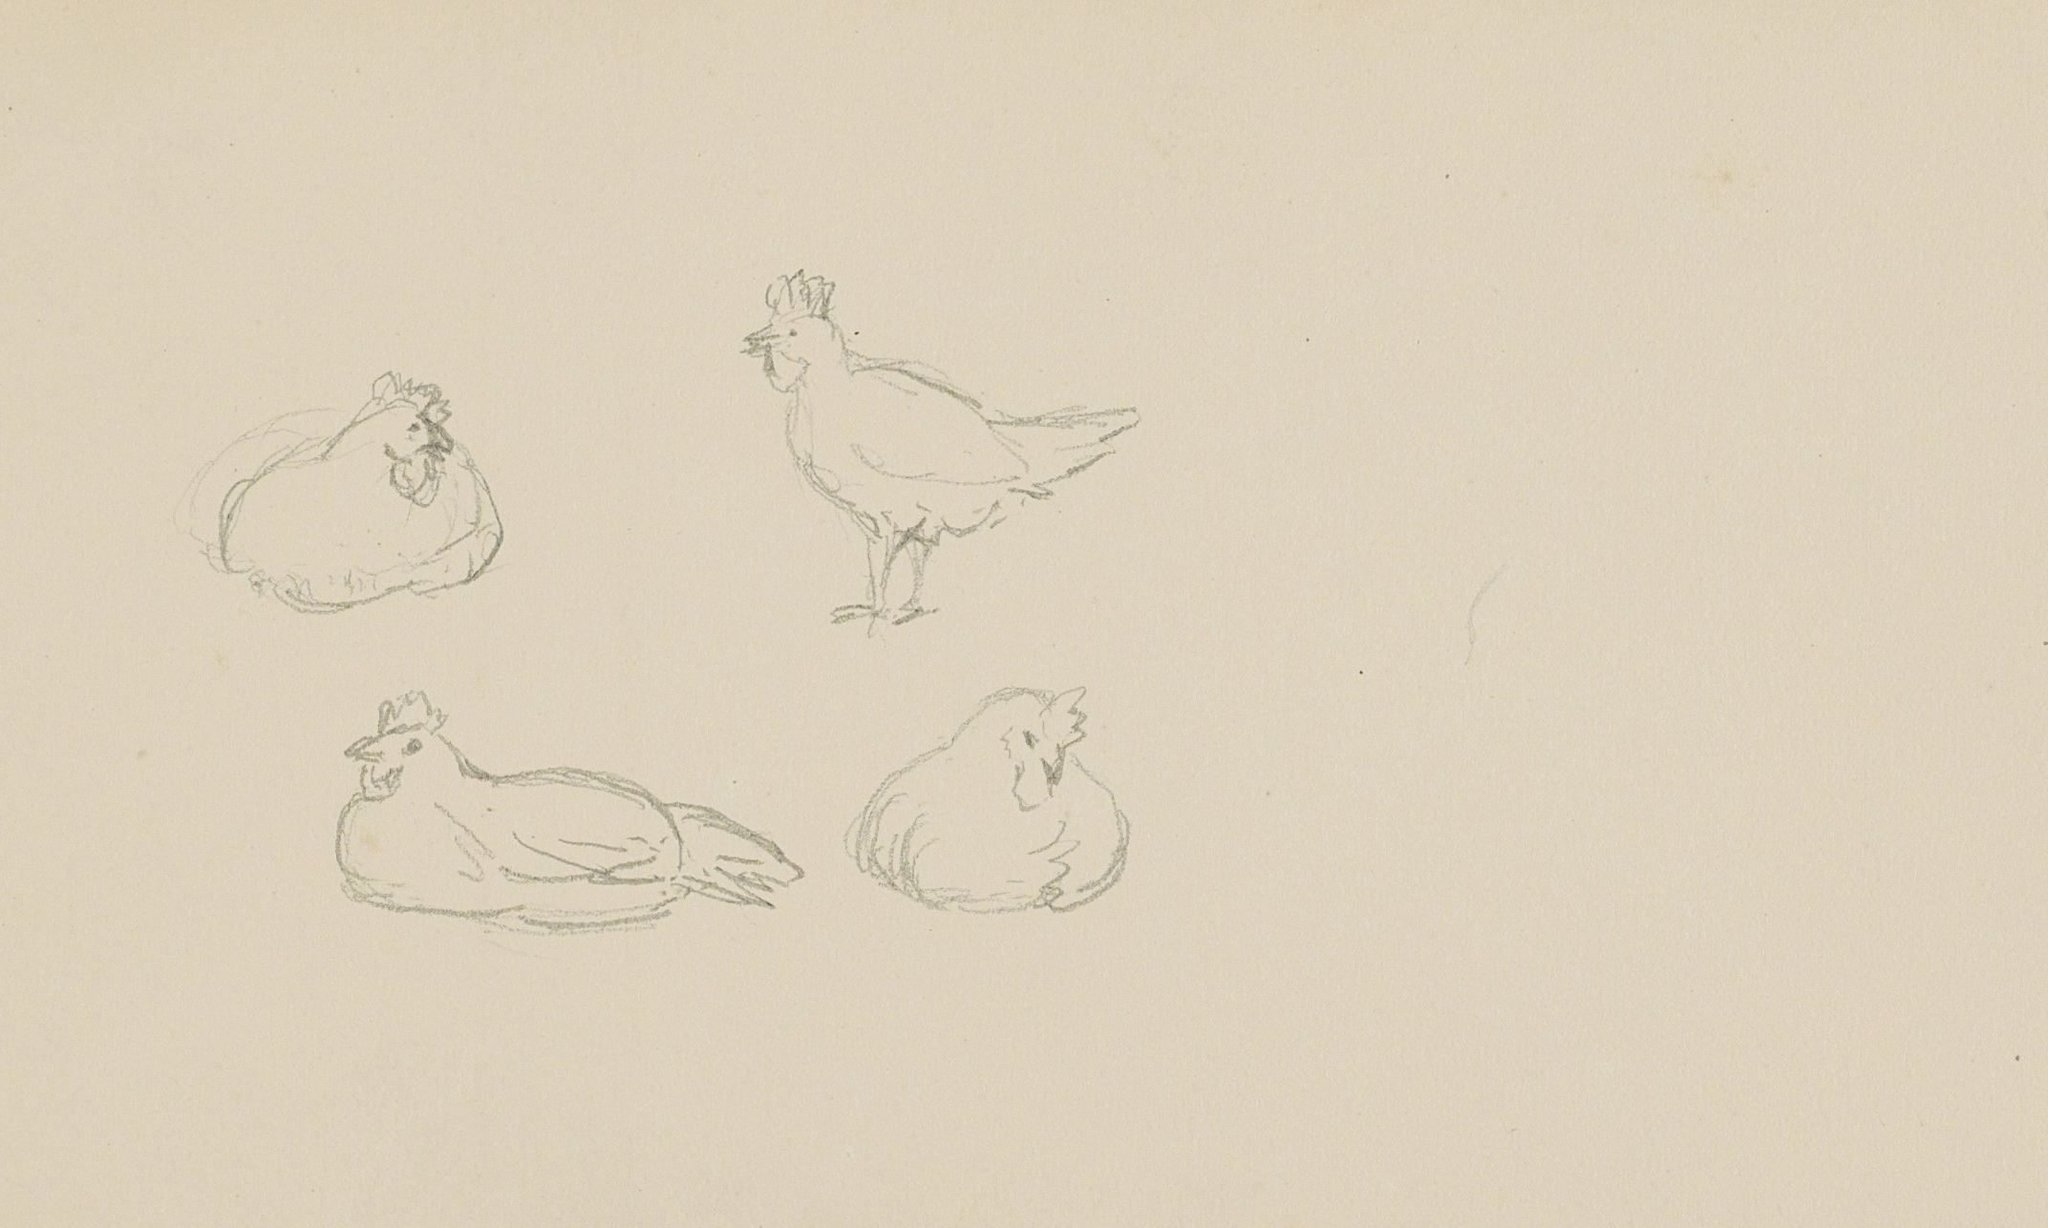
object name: sketchbook leaf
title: Kippen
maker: anna catharina maria van eeghen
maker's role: draughtsman, print maker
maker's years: 1878-1924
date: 1888-1901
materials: paper, pencil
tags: fowl (cock, hen, chicken, etc.)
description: Blad 21 recto uit een schetsboek met 33 bladen.